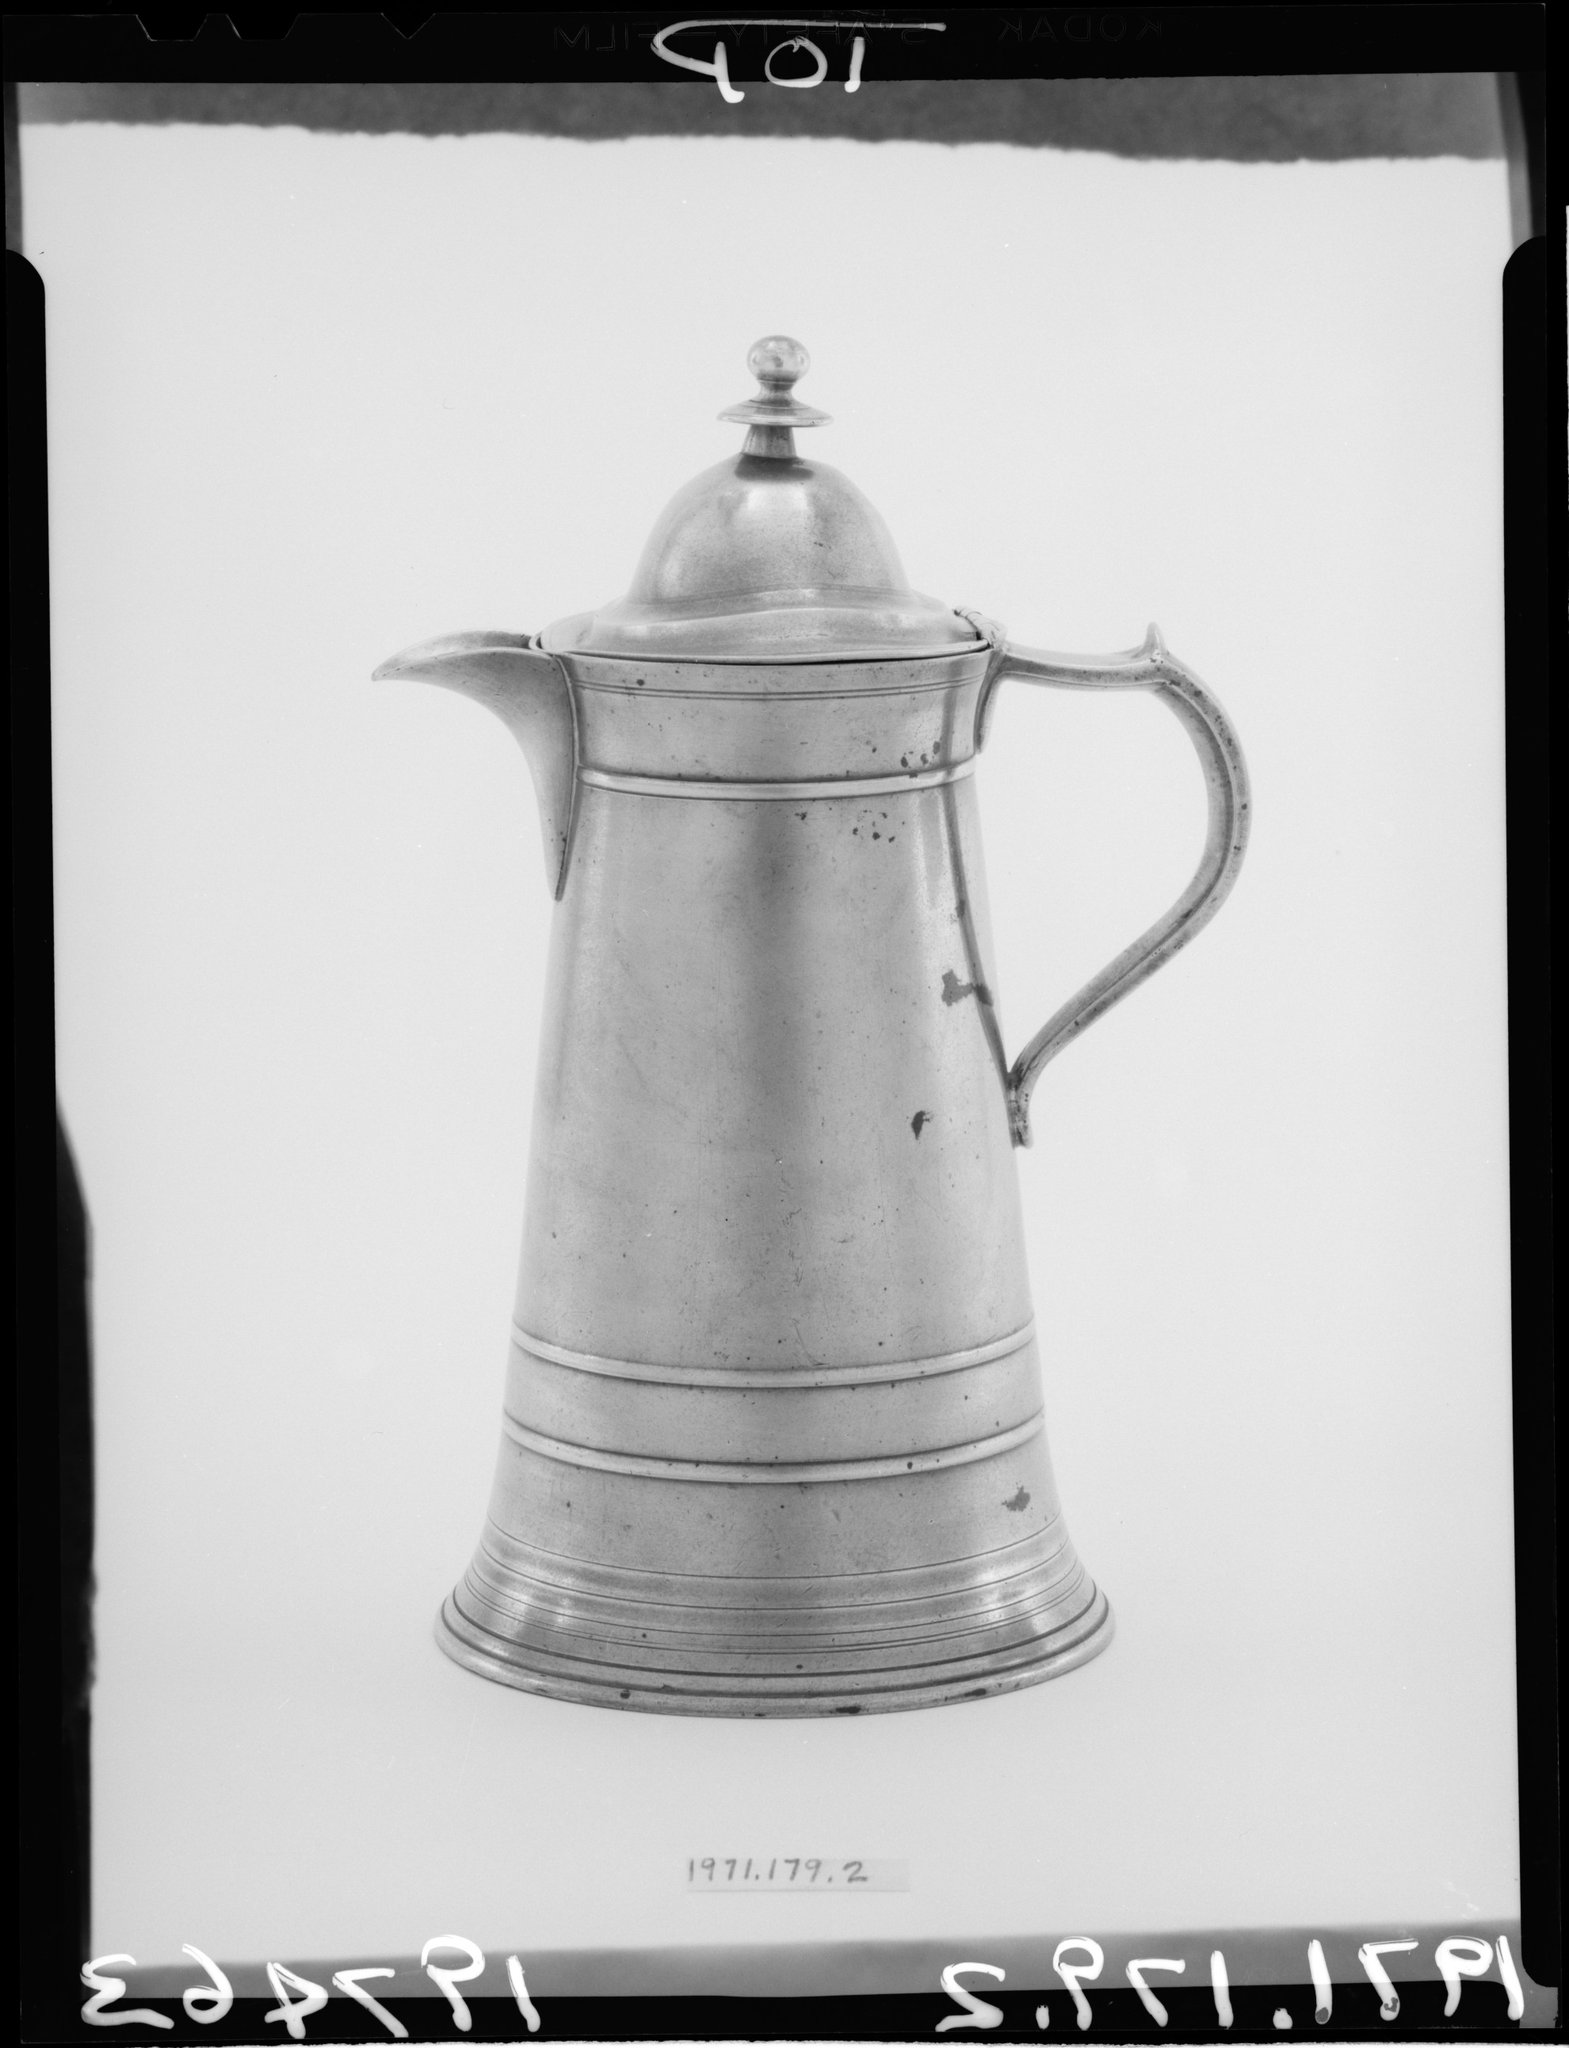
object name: flagon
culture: american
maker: rufus dunham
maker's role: maker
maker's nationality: american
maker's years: 1815-1882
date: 1837-1860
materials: pewter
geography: united states